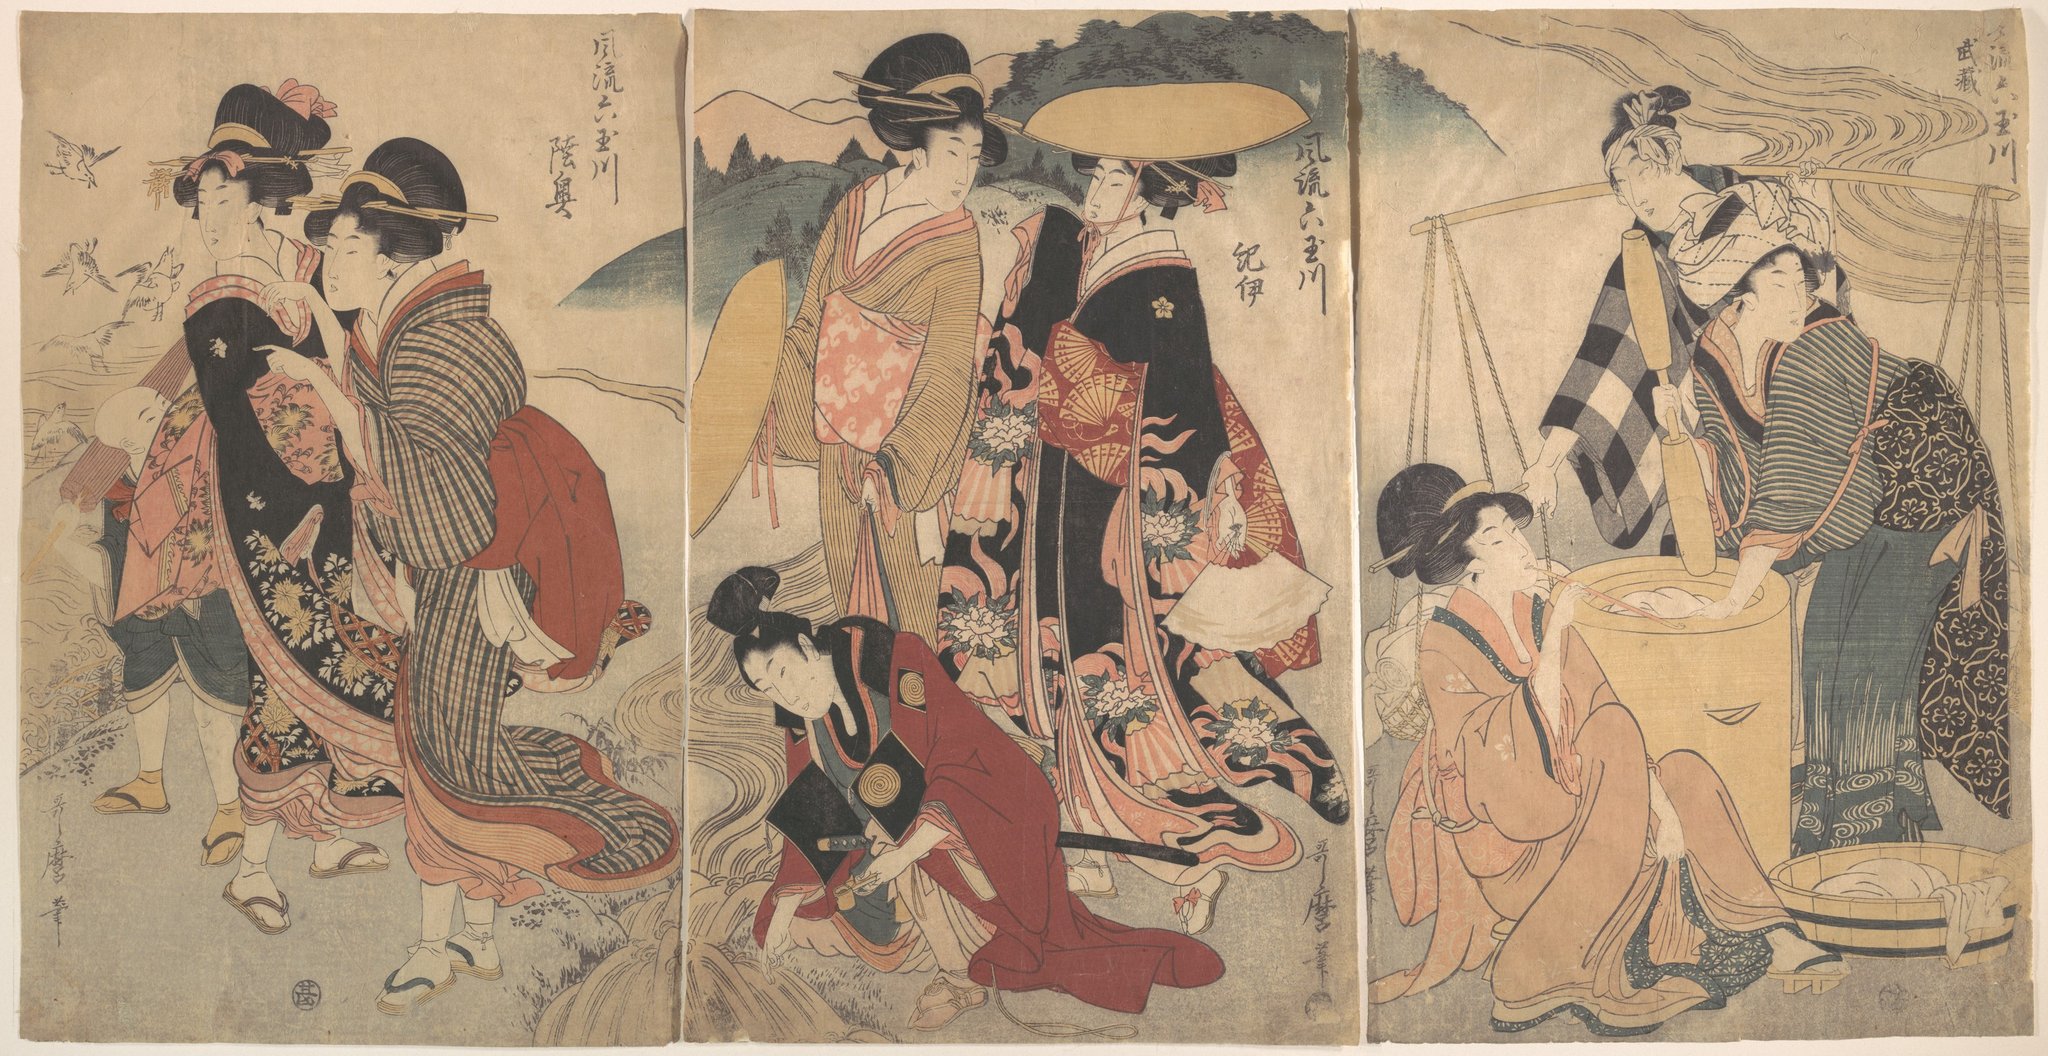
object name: print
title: Women and a Man in the Country; Some pageant(?)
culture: japanese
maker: kitagawa utamaro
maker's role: artist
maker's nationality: japanese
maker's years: 1754-1806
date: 1754-1806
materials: ink, paper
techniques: woodblock print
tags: men,women,smoking